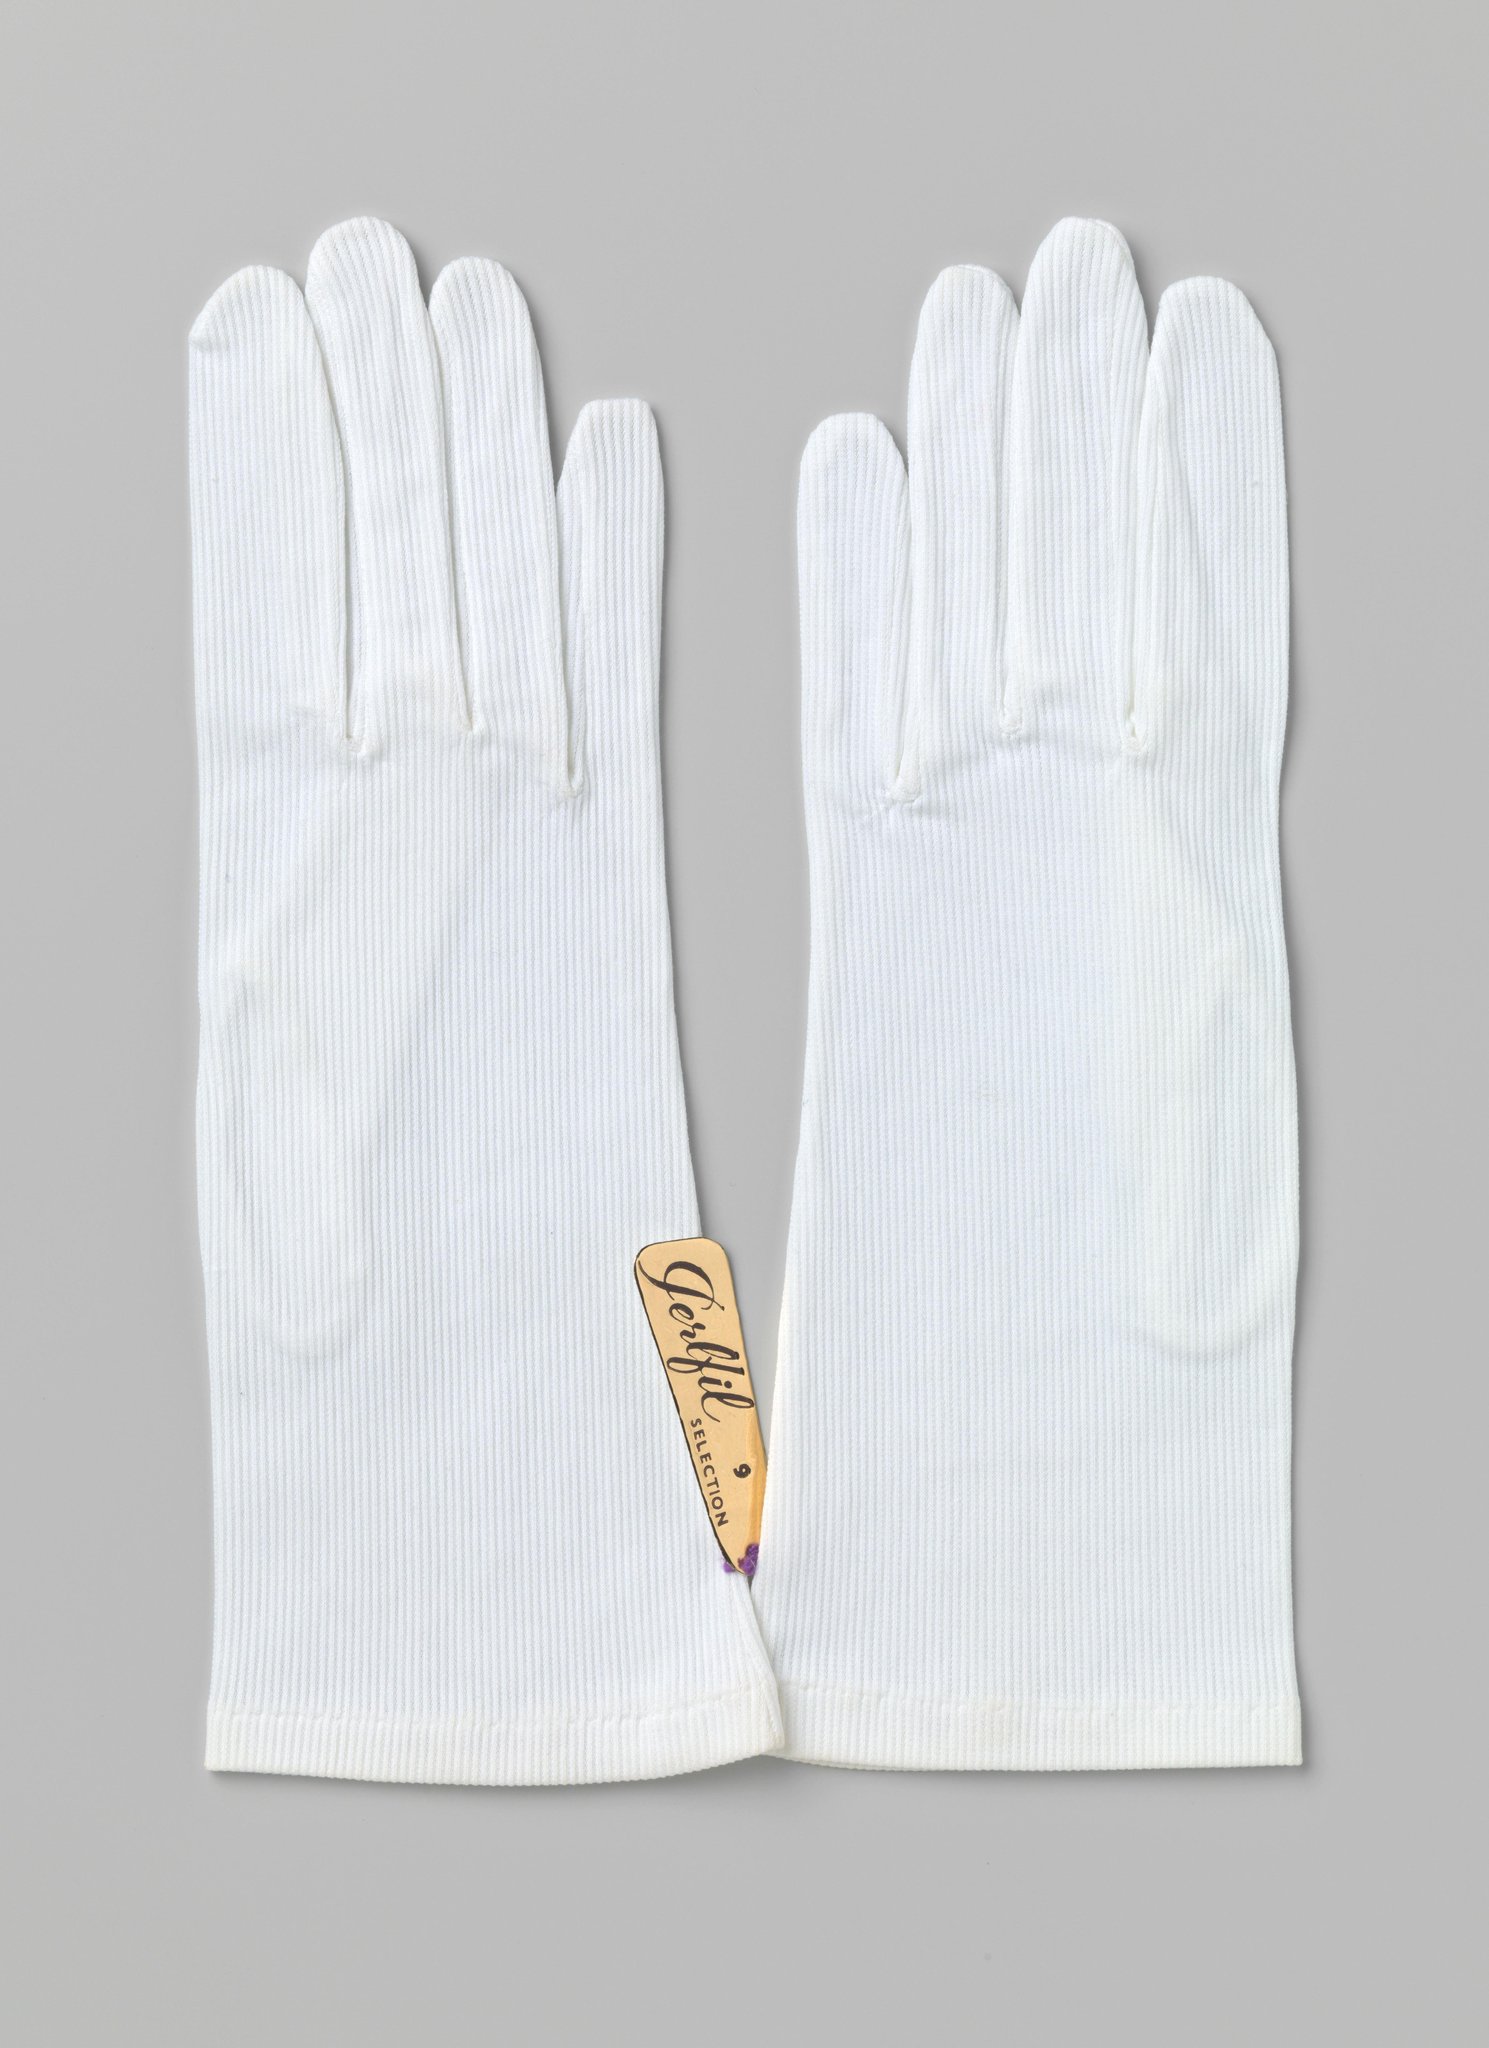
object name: glove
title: Handschoen van wit katoen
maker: perlfil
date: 1950-1970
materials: cotton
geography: netherlands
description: Rechterhandschoen van wit katoen. Ongedragen paar met merklabel eraan bevestigd en prijskaartje van de Bijenkorf aanwezig.